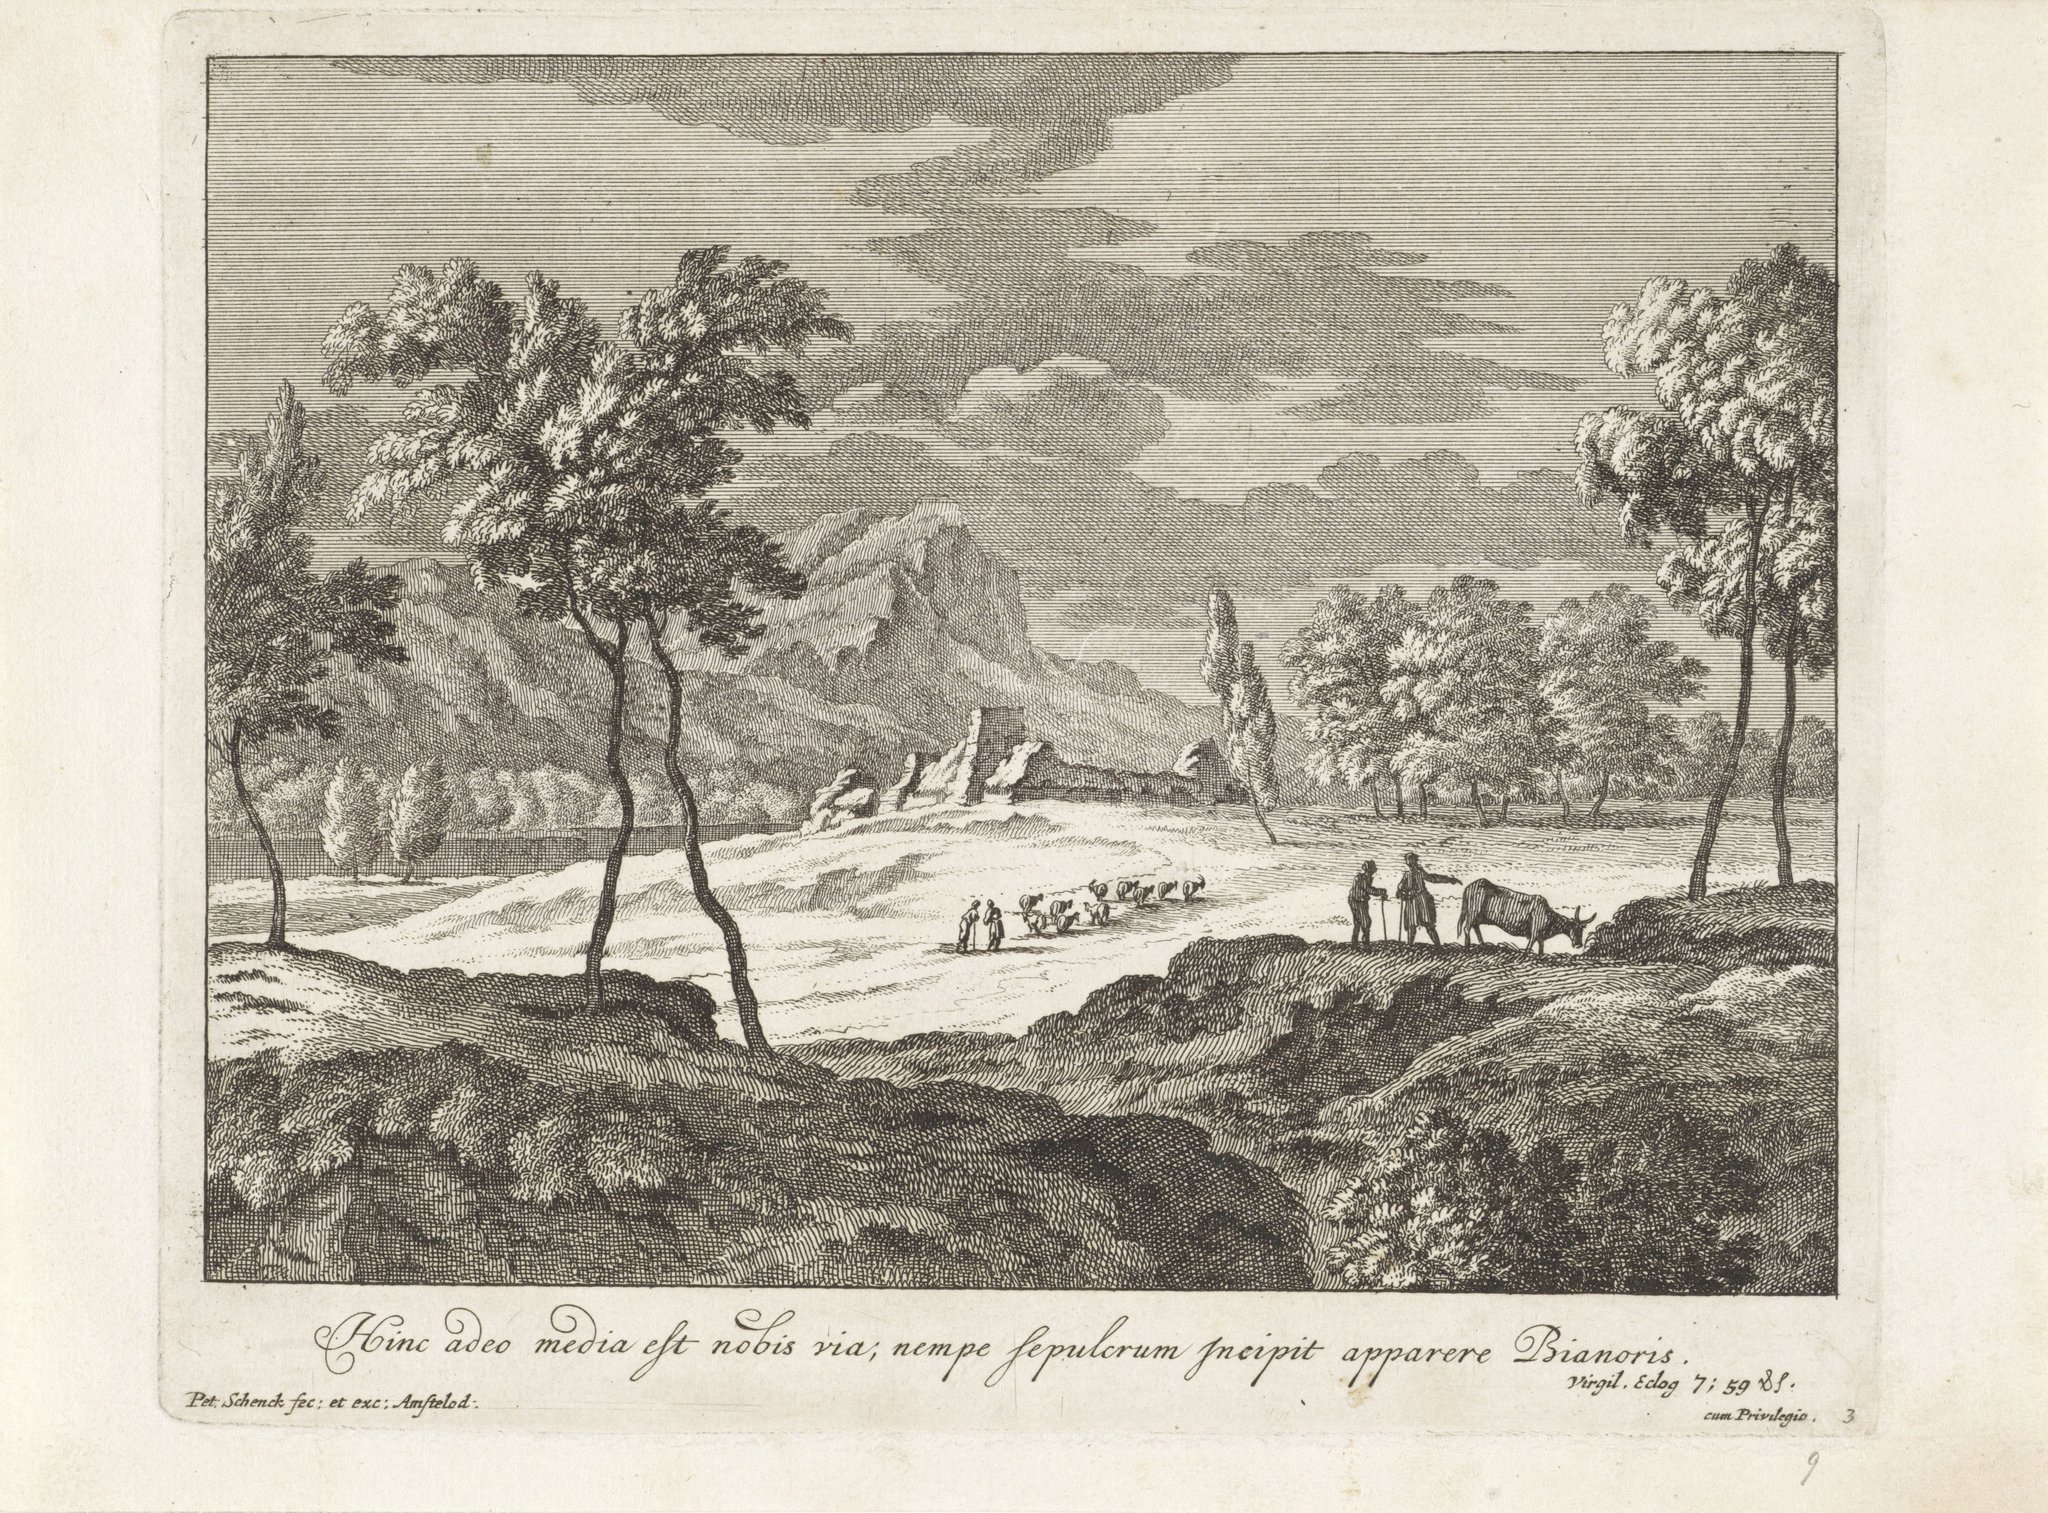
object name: print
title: Herders bij schapen op een veld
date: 1675-1711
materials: paper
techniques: etching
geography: amsterdam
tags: herding, herdsman, herdswoman, shepherd, shepherdess, cowherd, etc., landscapes in the temperate zone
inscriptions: collector's mark: Lugt 2760, collector's mark: Lugt 2166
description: Landschap met een open vlakte waarop herders met een kudde schapen. Onder de voorstelling een tekst in het Latijn en een verwijzing naar Virgilius.